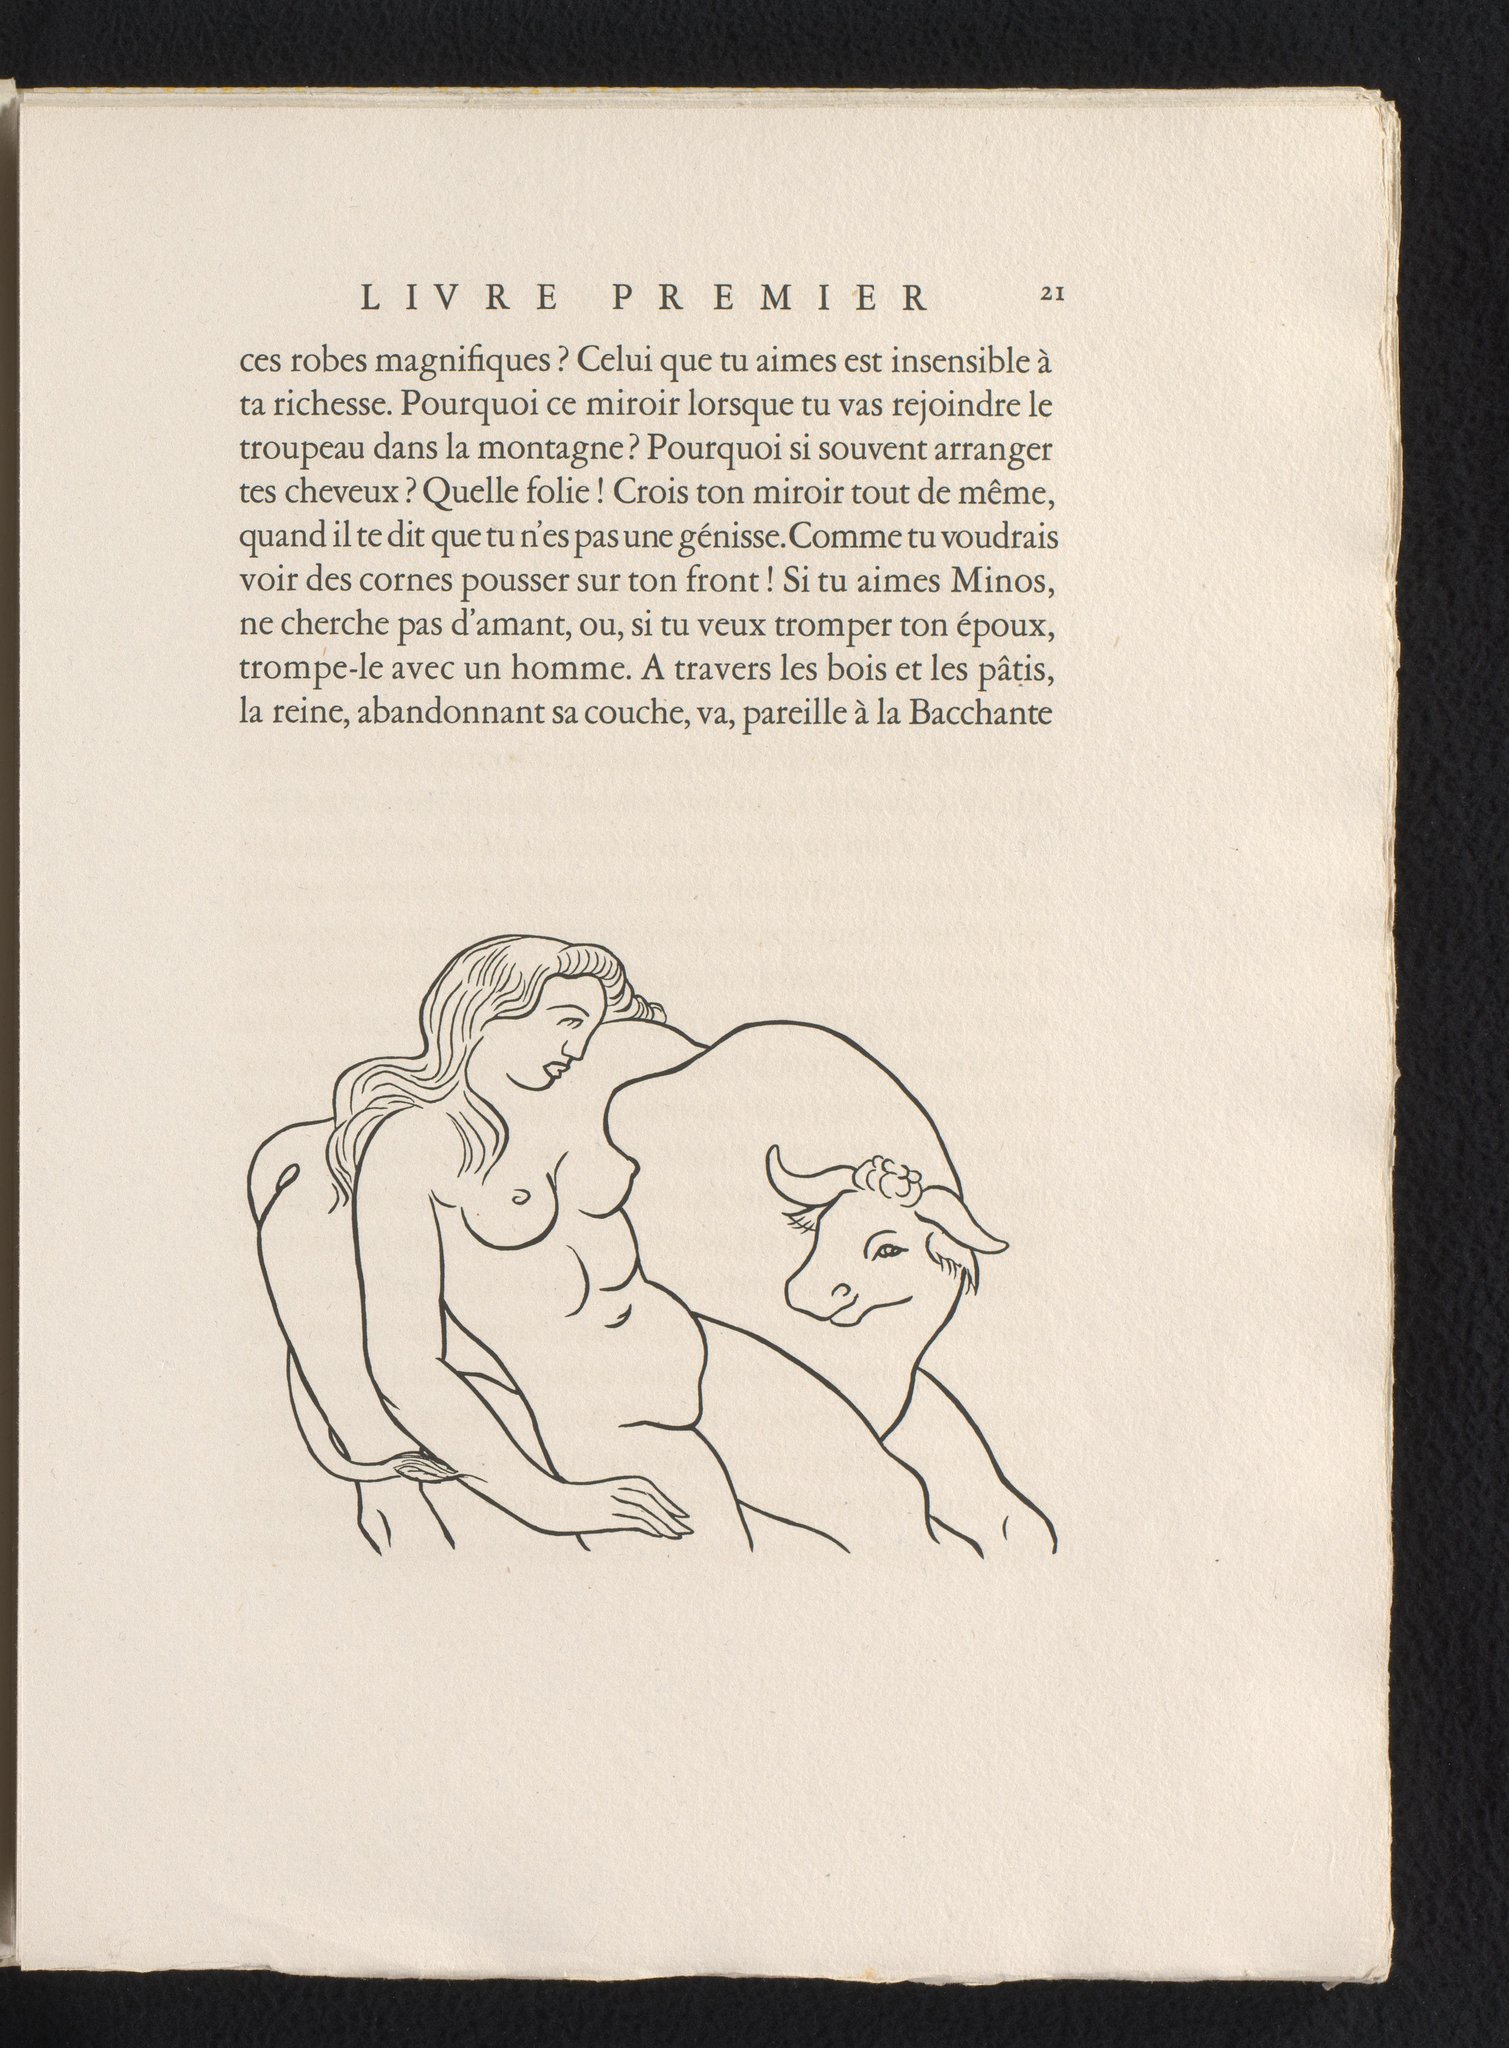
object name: book illustration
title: Pasiphaë en de witte stier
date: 1935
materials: paper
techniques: letterpress printing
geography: lausanne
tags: bull, pasiphae enamoured of a white bull, woman (showing herself) undressed, quasi-nude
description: Prent in: Ovidius Naso, Publius. L'art d'aimer. [Vertaald uit het Latijn door] Henri Bornecque. Parijs/Lausanne: Les frères Gonin, 1935, p. 21.